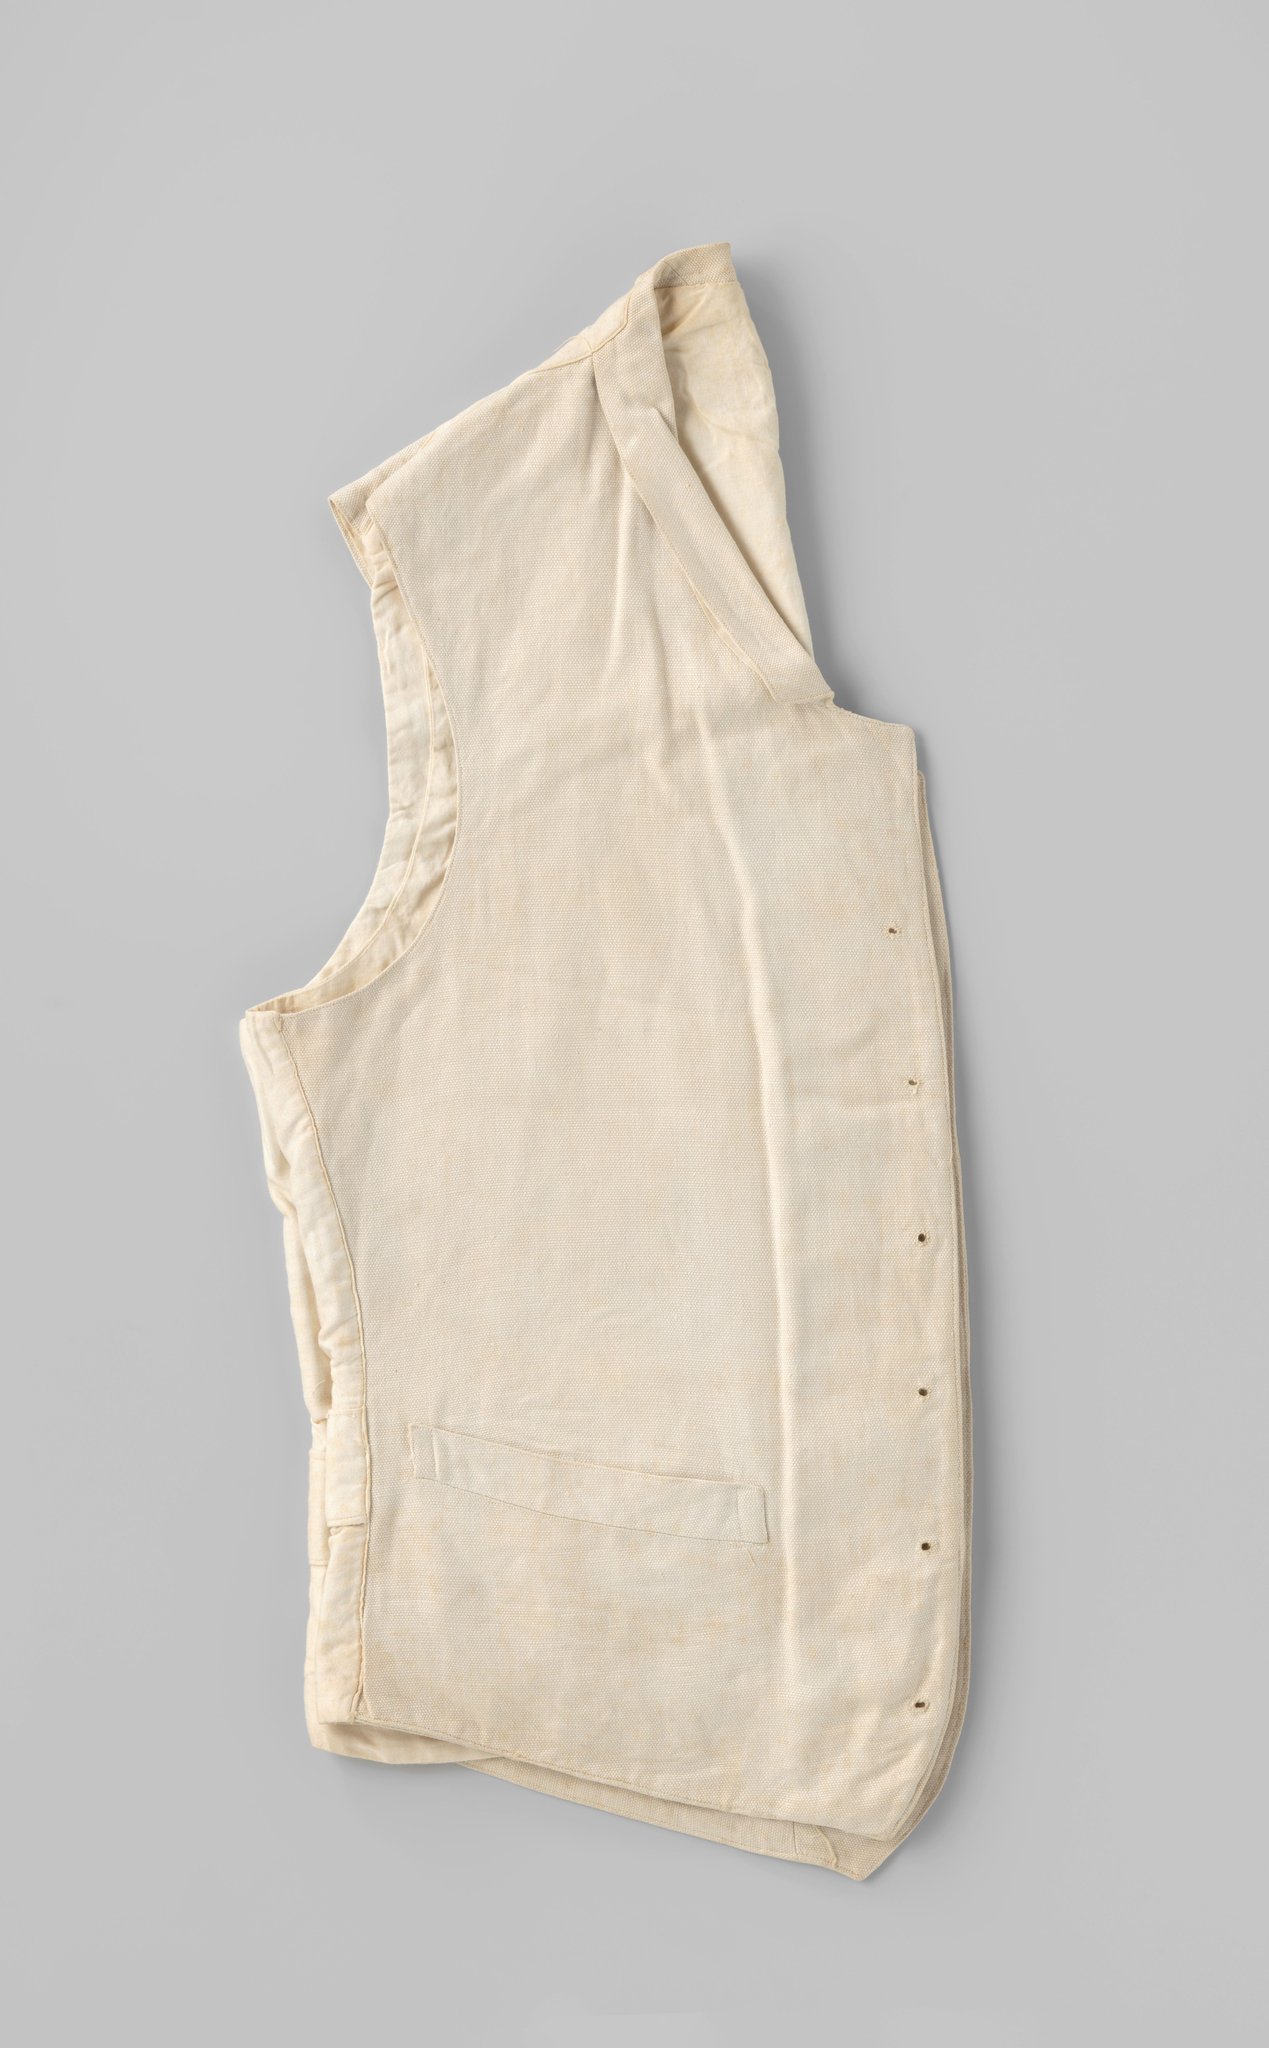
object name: main garment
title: Avondvest van wit linnen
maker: Anonymous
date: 1915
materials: linen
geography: brussels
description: Avondvest van wit linnen. De voorpanden zijn onderaan in een booglijn gesneden met twee heel kleine punten. Vrij hoge V-hals met liggend, hoekig afgesneden kraagje. Twee normale, schuine, insteekzakken en één kleiner zakje ter linkerzijde. Zes knoopsgaten, links, tegenover zes cordongaatjes voor losse knoopjes, Rug van wit satinet, met V-inkeping. Vastgenaaide rugbanden.